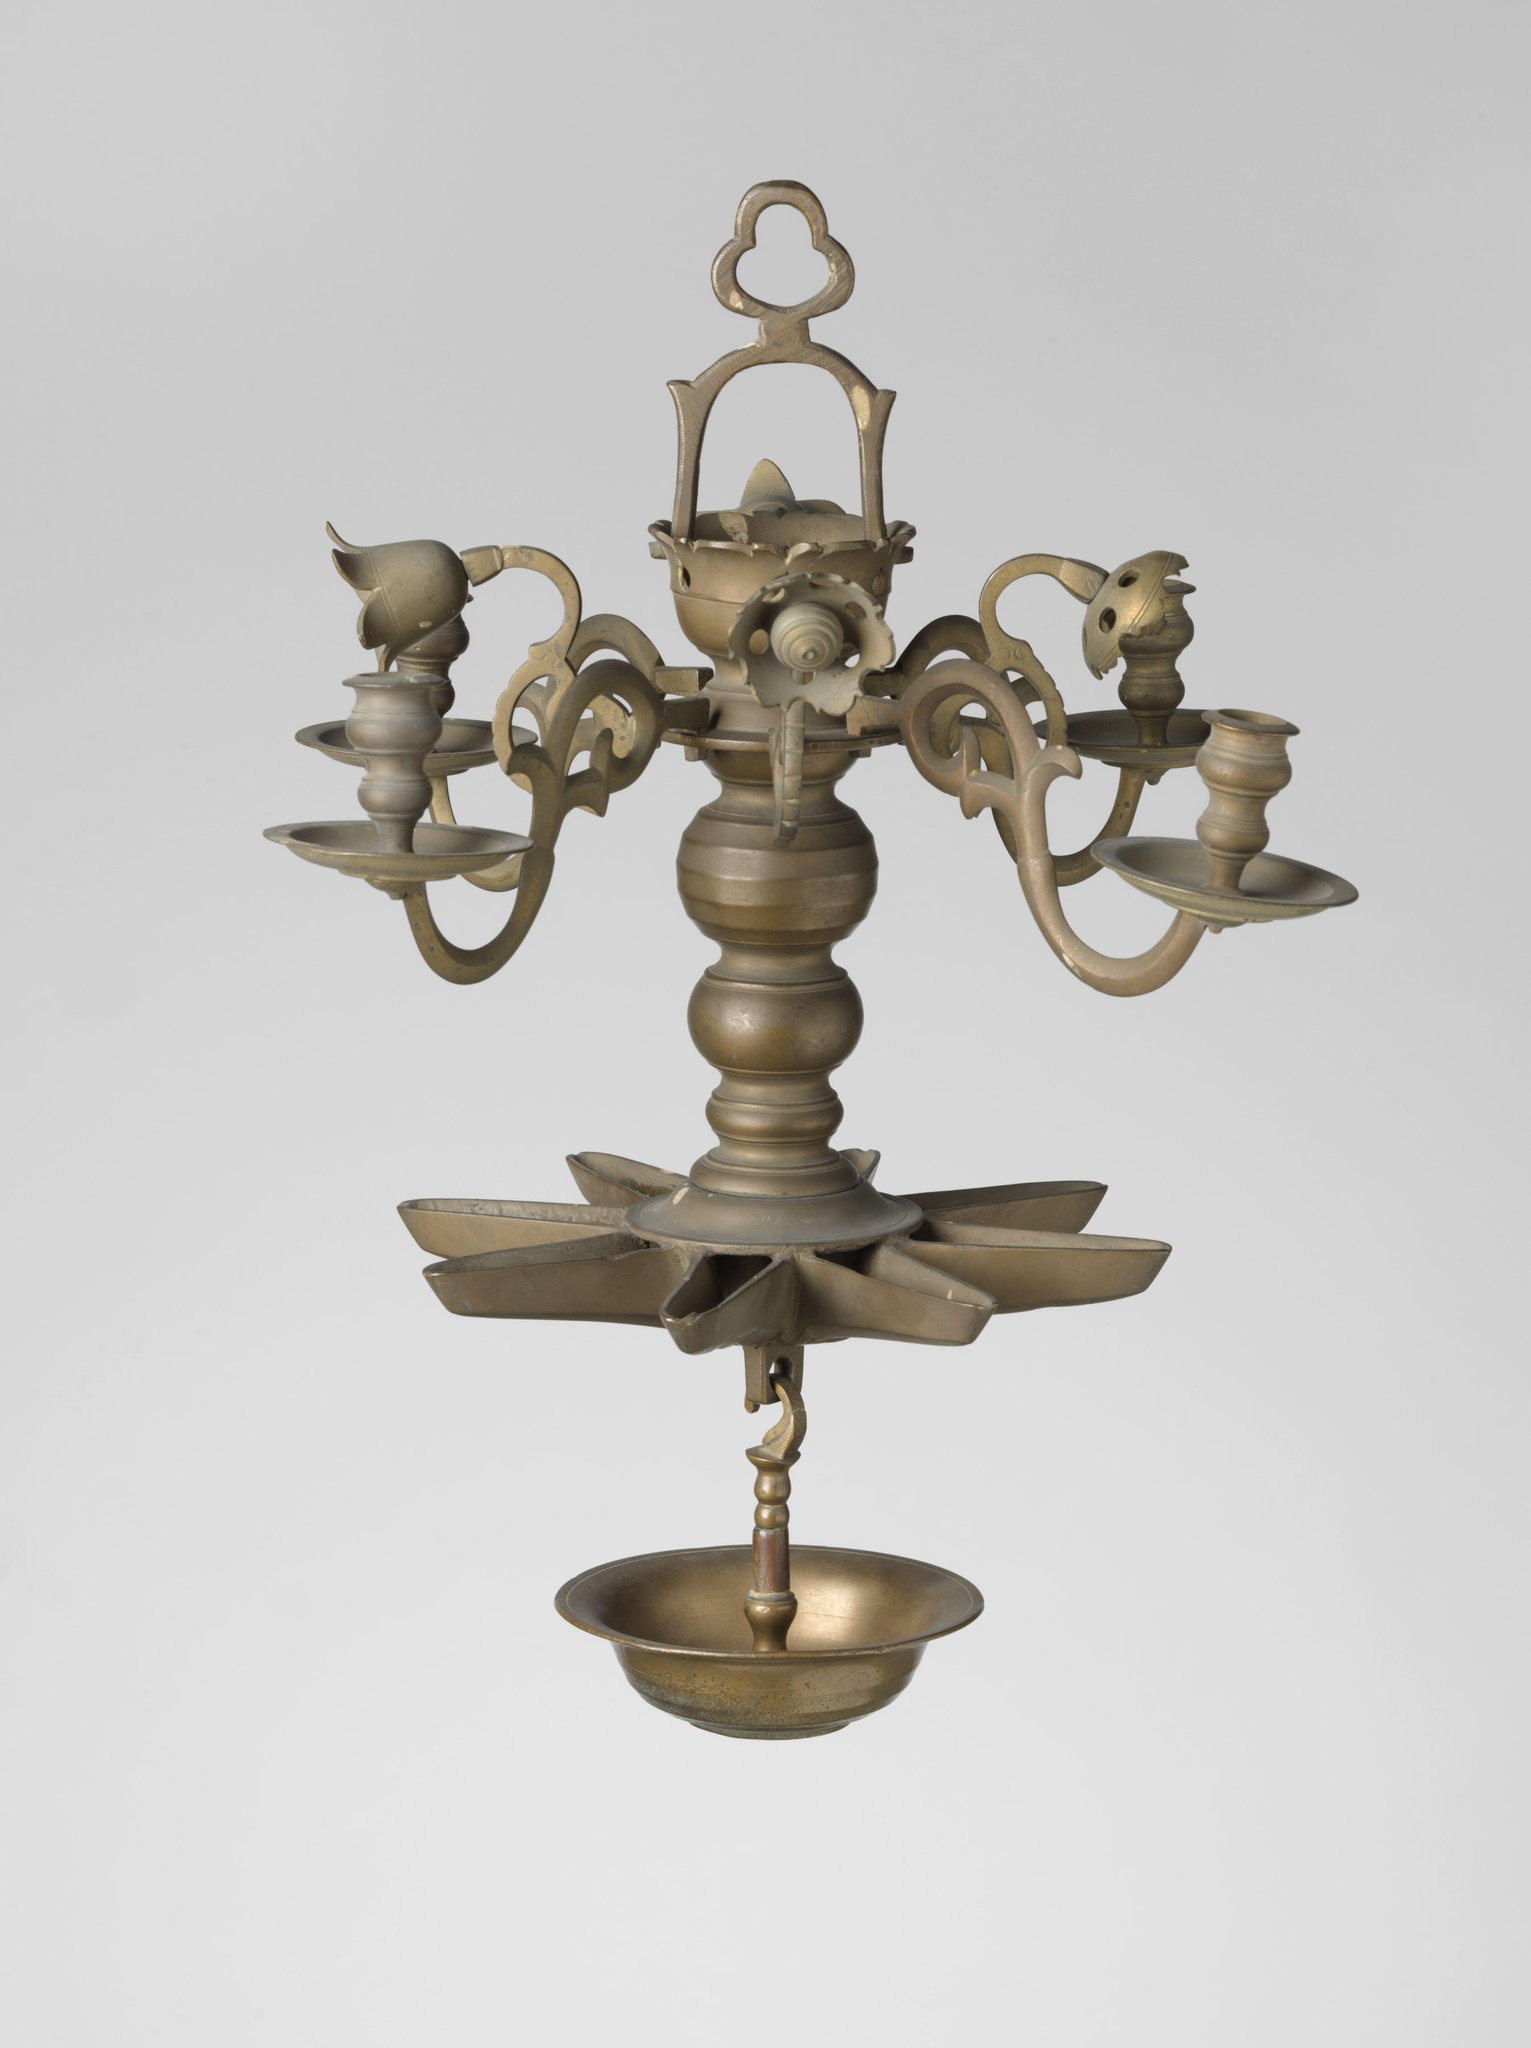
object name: sabbath lamp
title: Druipbak van een sabbathlamp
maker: Anonymous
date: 1700-1800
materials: brass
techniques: casting, riveted, soldering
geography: nuremberg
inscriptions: maker's mark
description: Geprofileerde stang met druipbak van gegoten messing. Met de haak aan de bovenzijde van stang kan de druipbak onder de sabbathlamp worden gehangen. De bak is aan de stang geklonken en later gesoldeerd. Op de bovenrand van de bak is het teken van een engelenkop ingeslagen.